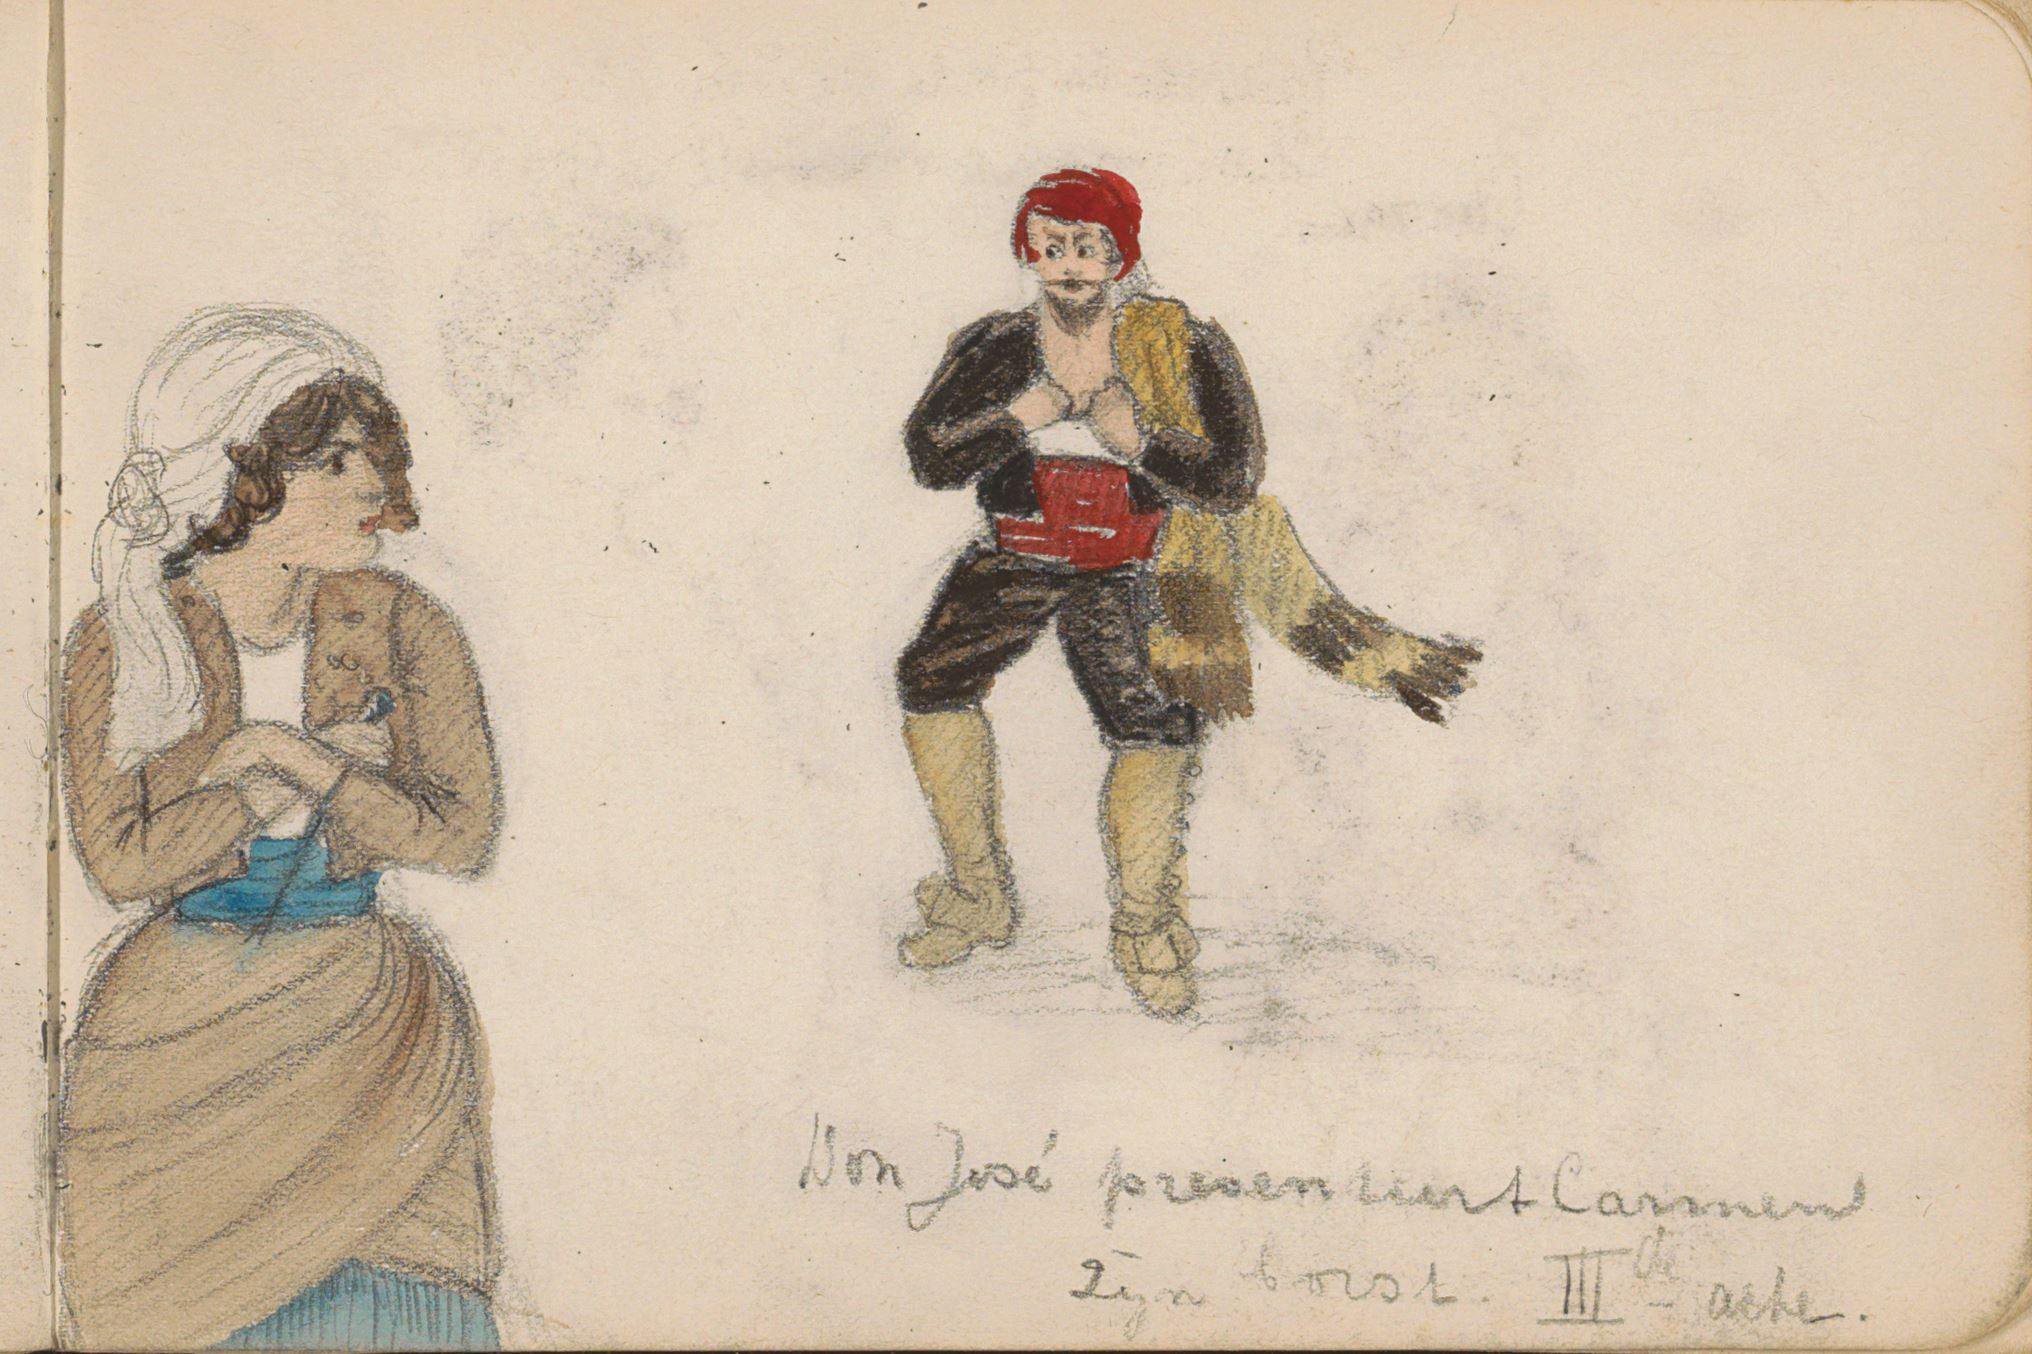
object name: sketchbook leaf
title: Don José presenteert Carmen zijn borst, scène uit de derde acte van de opera Carmen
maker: julie de graag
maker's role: draughtsman, print maker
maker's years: 1877-1924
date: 1894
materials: paper, pencil, watercolor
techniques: brush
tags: portrait of opera-singer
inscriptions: annotation: ‘Don José presenteert Carmen/ zijn borst. IIIde acte.’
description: Blad 24 recto uit een schetsboek met 35 bladen.